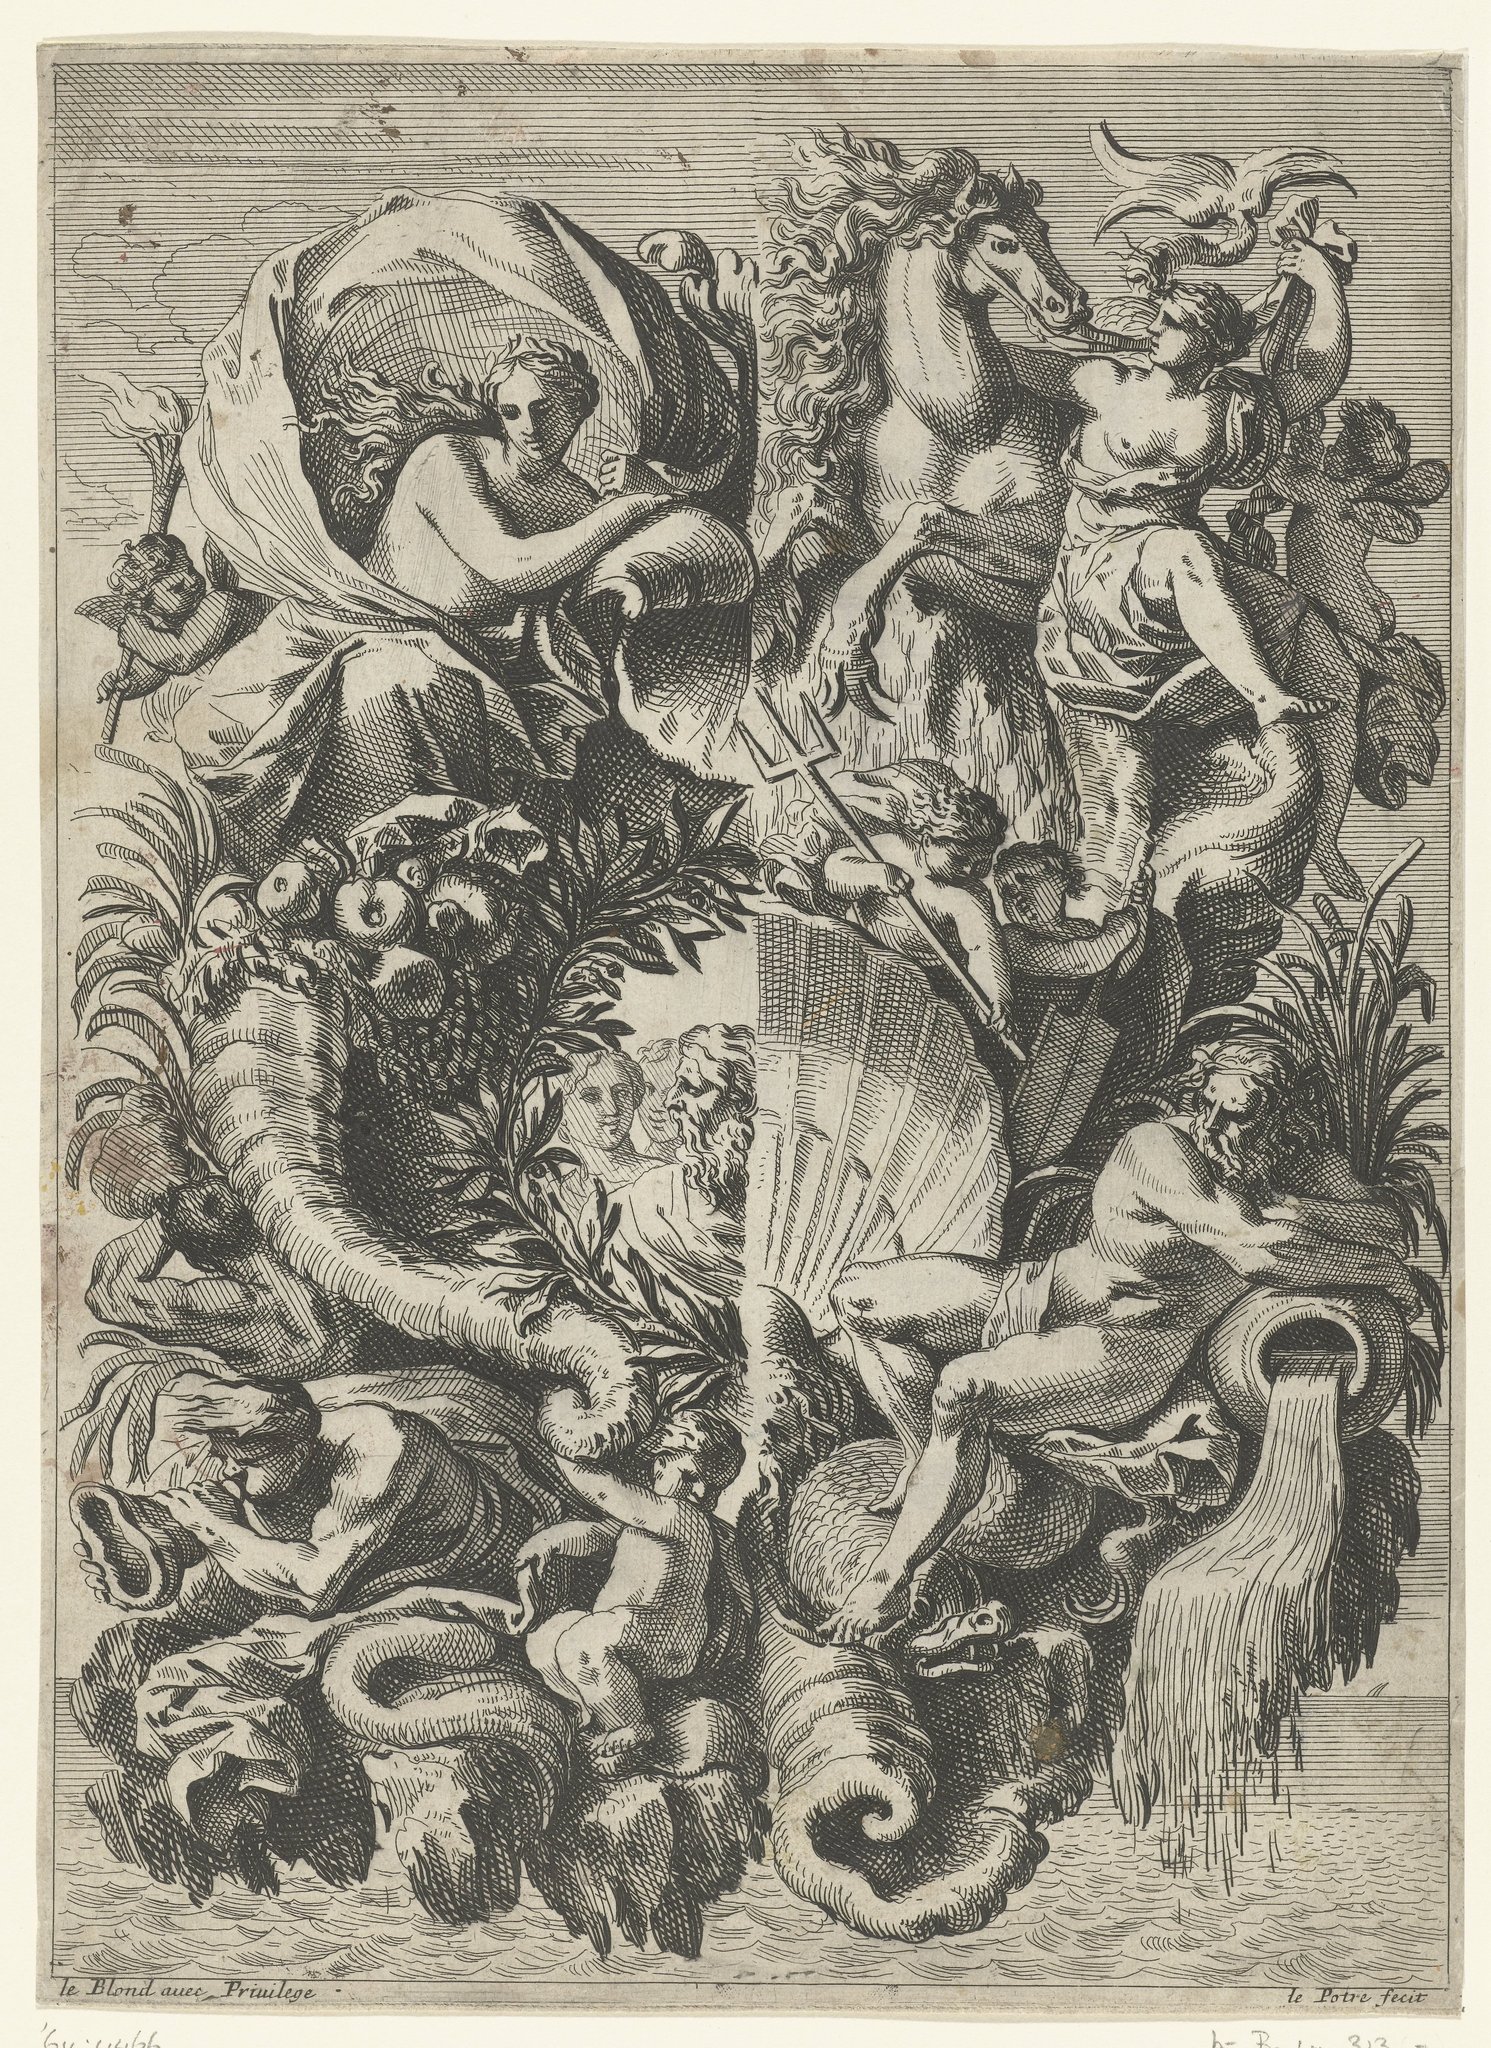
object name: ornament print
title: Grote cartouches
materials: paper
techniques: etching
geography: france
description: Rechtsonder zit een riviergod. Uit serie van 6 bladen, elk met een variant voor de rechterhelft.